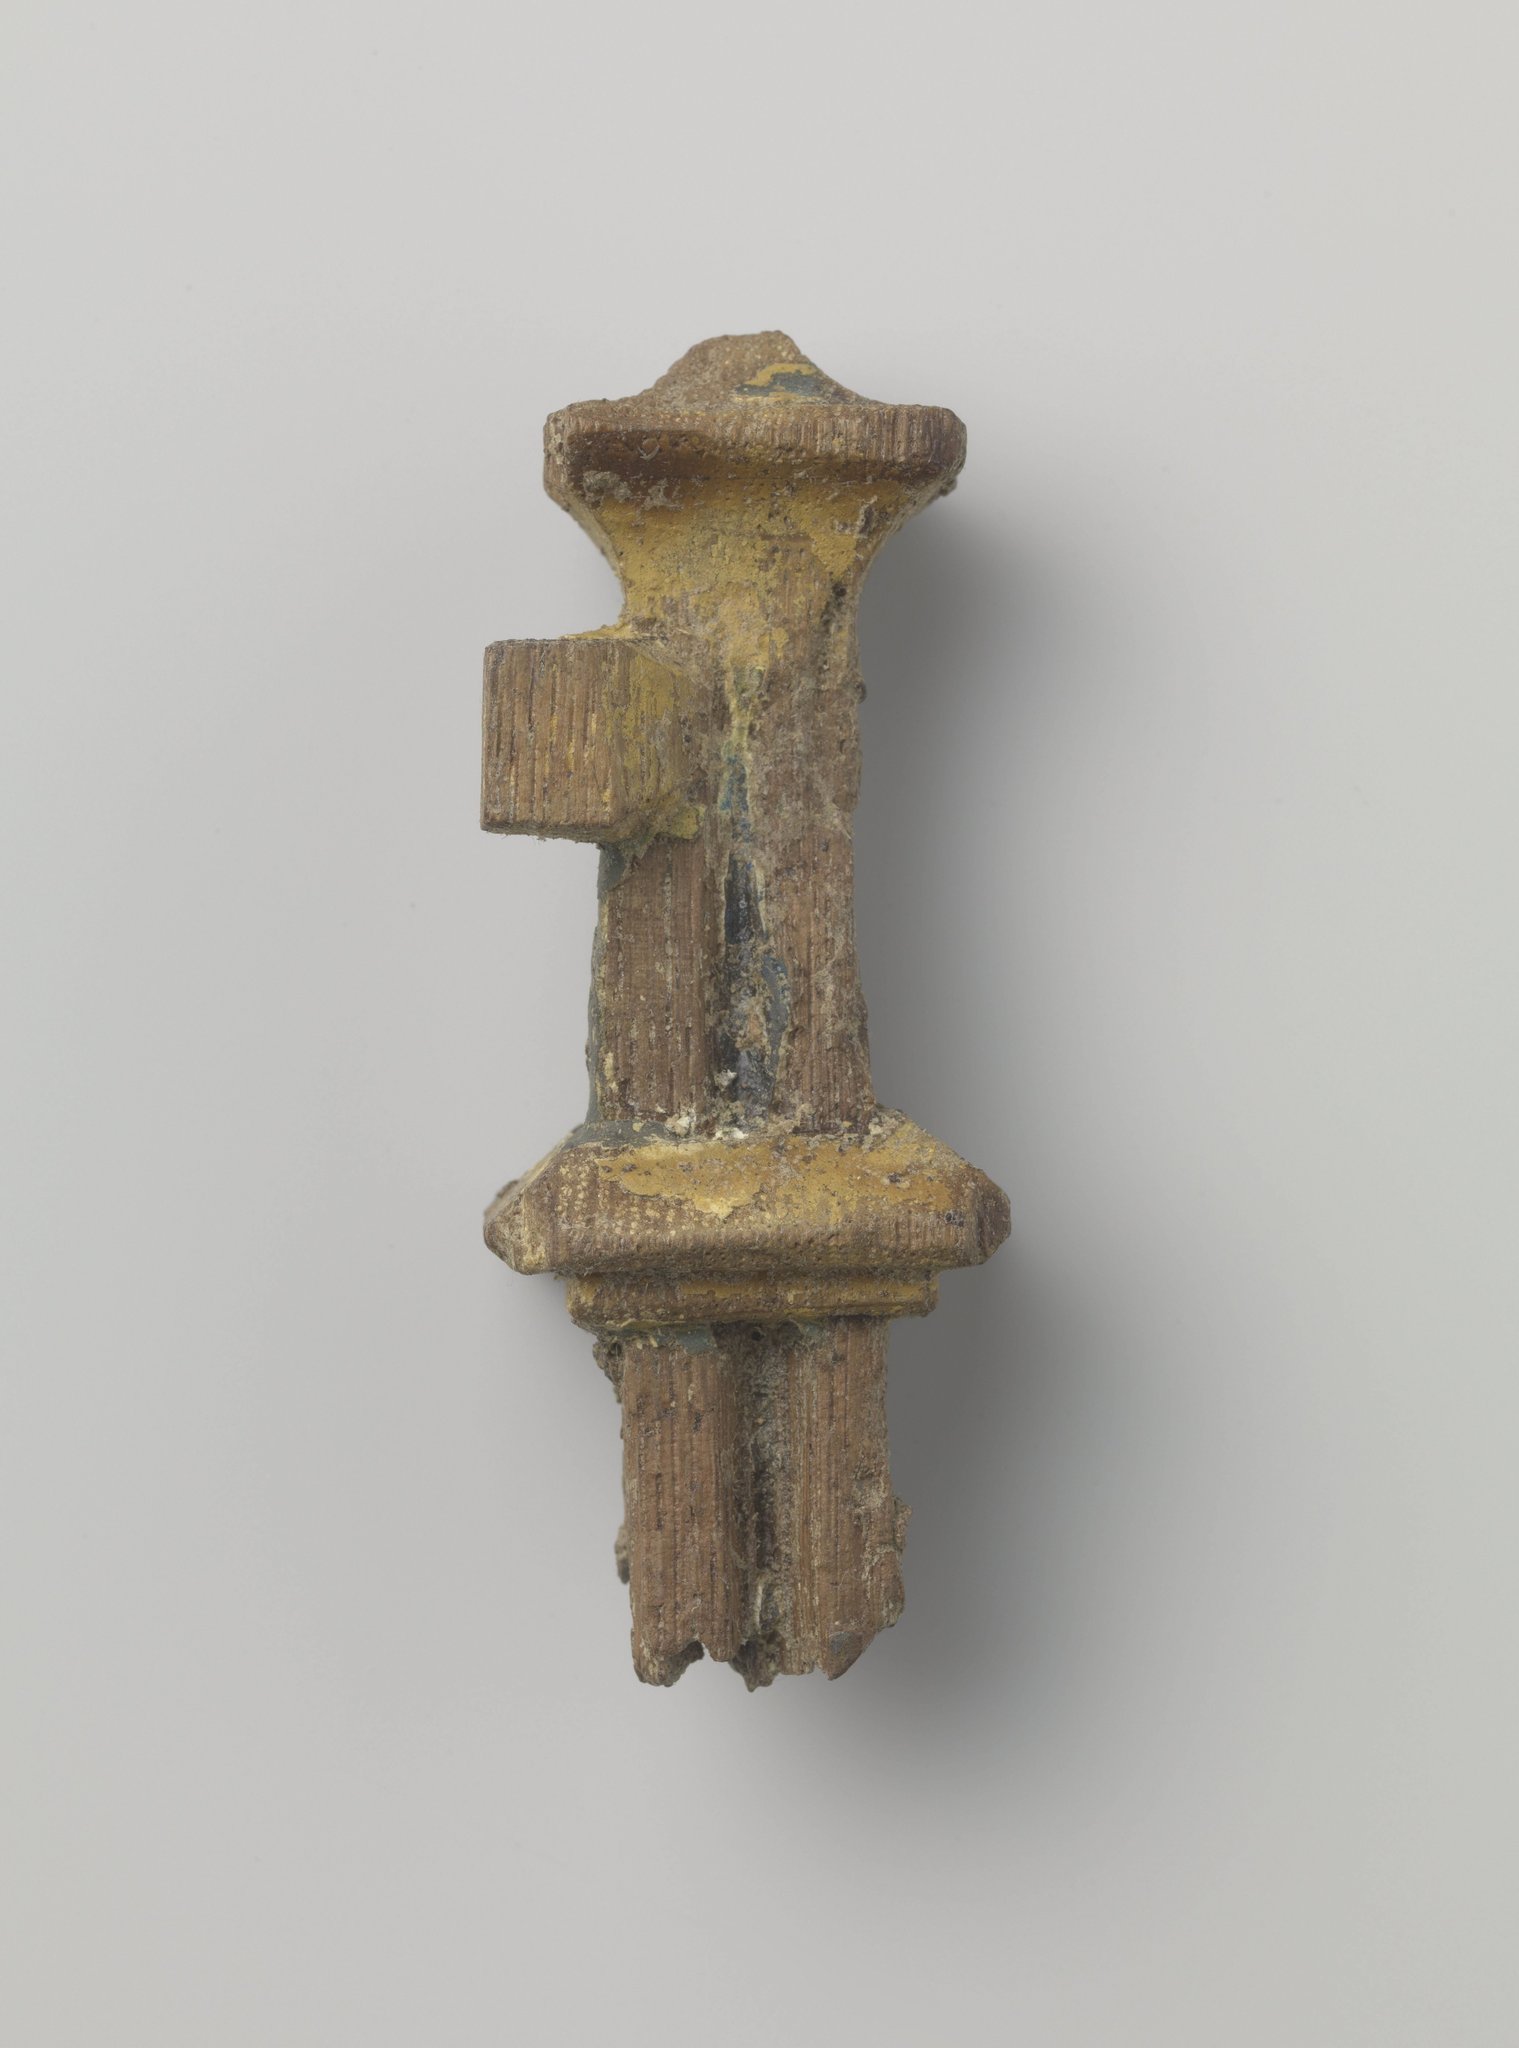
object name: sculpture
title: Fragment (van een altaarkast?); (mogelijk) behorend tot het retabel van Soest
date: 1475-1499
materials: wood